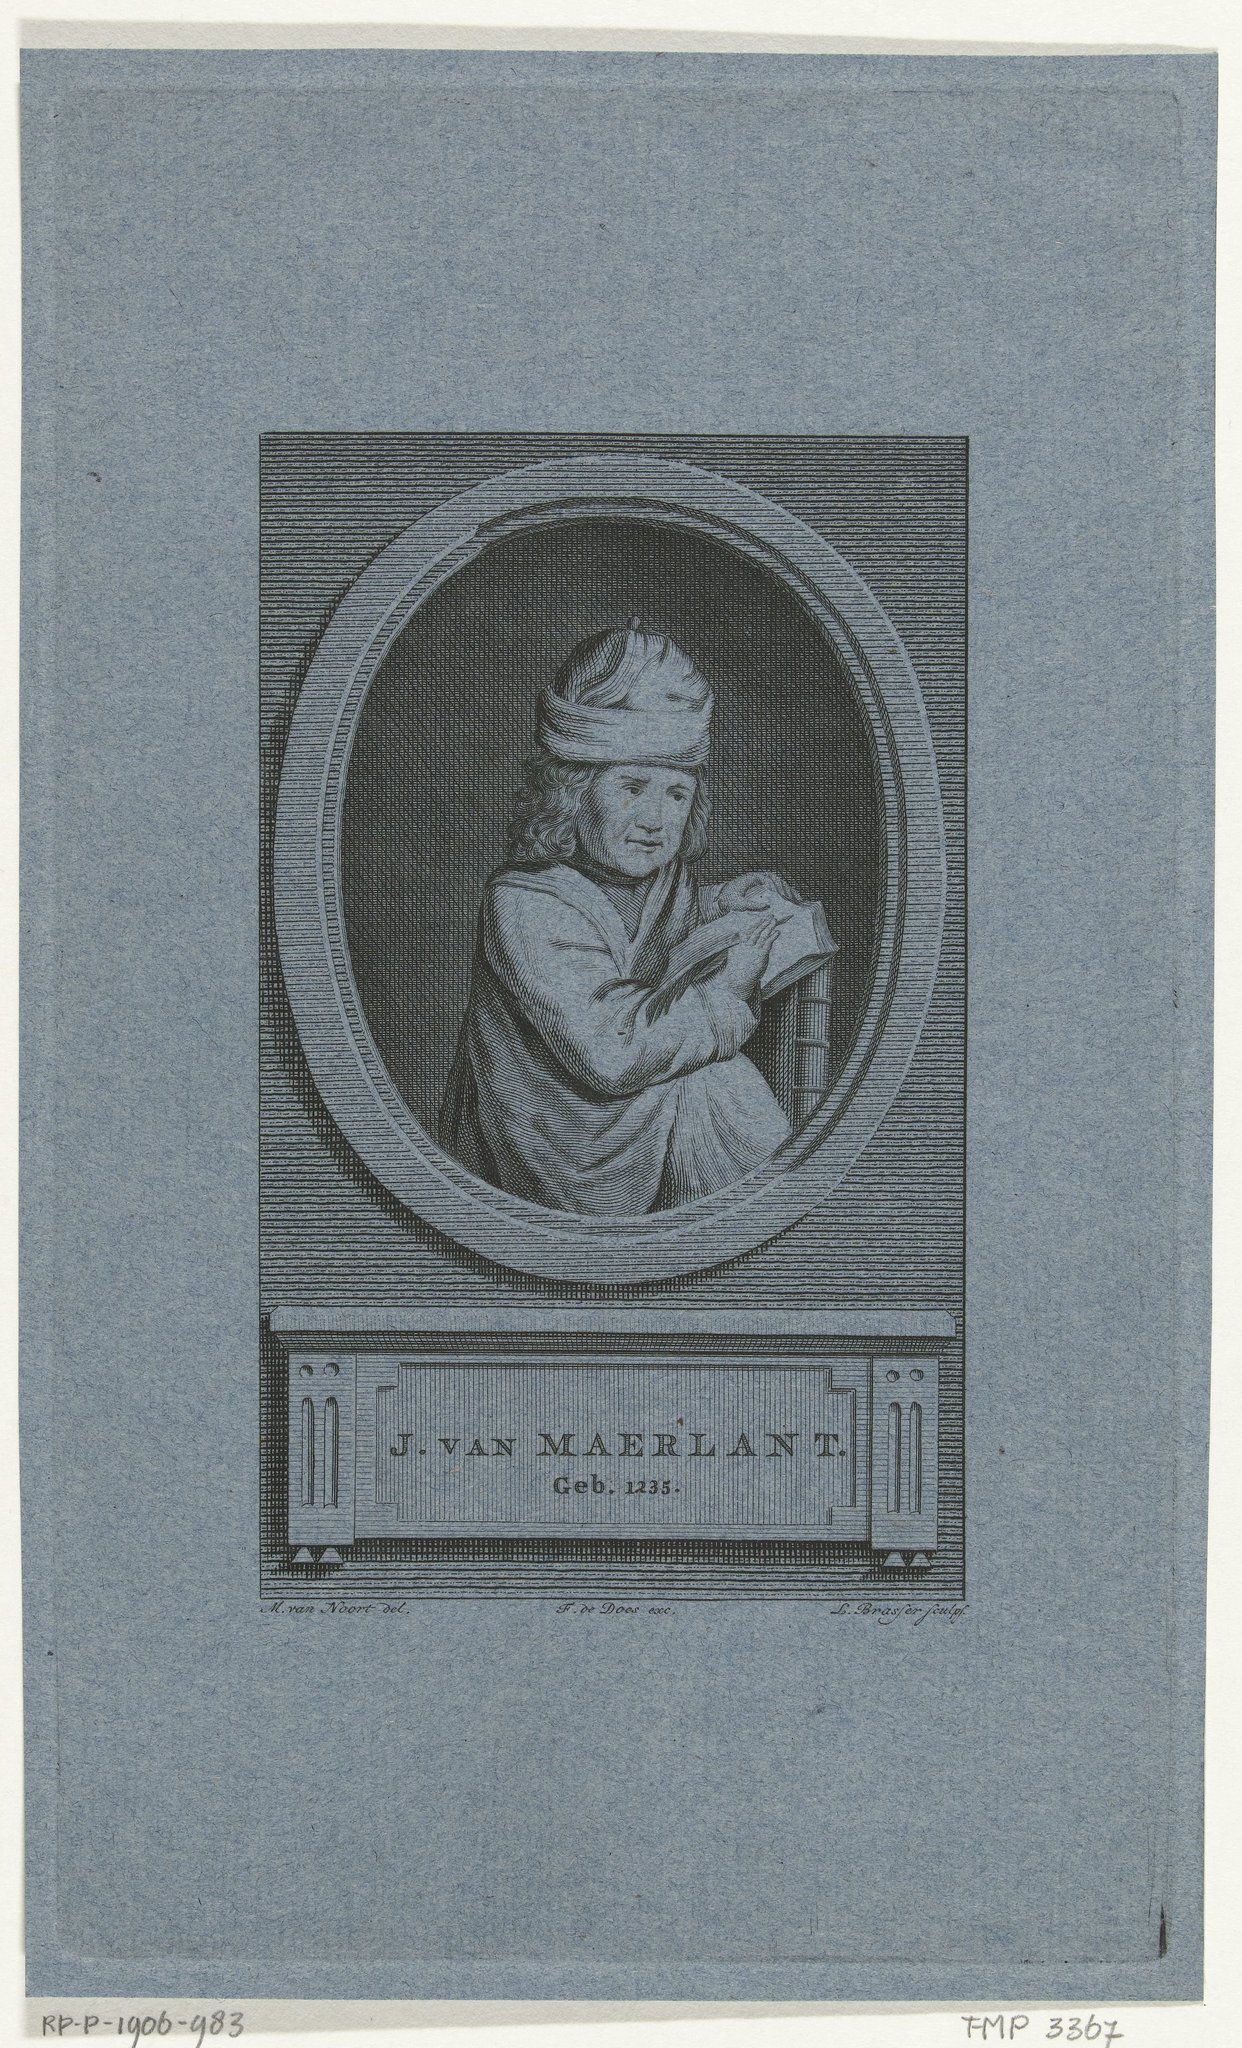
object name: print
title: J. van Maerlant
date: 1727-1793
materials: paper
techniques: engraving, etching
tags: bard, lyric poet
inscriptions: collector's mark: Lugt 2228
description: Portret van de dichter Jacob van Maerlant, zittend op een stoel in een gedraaide houding terwijl hij met een ganzenveer schrijft in een boek dat rust op de rugleuning.